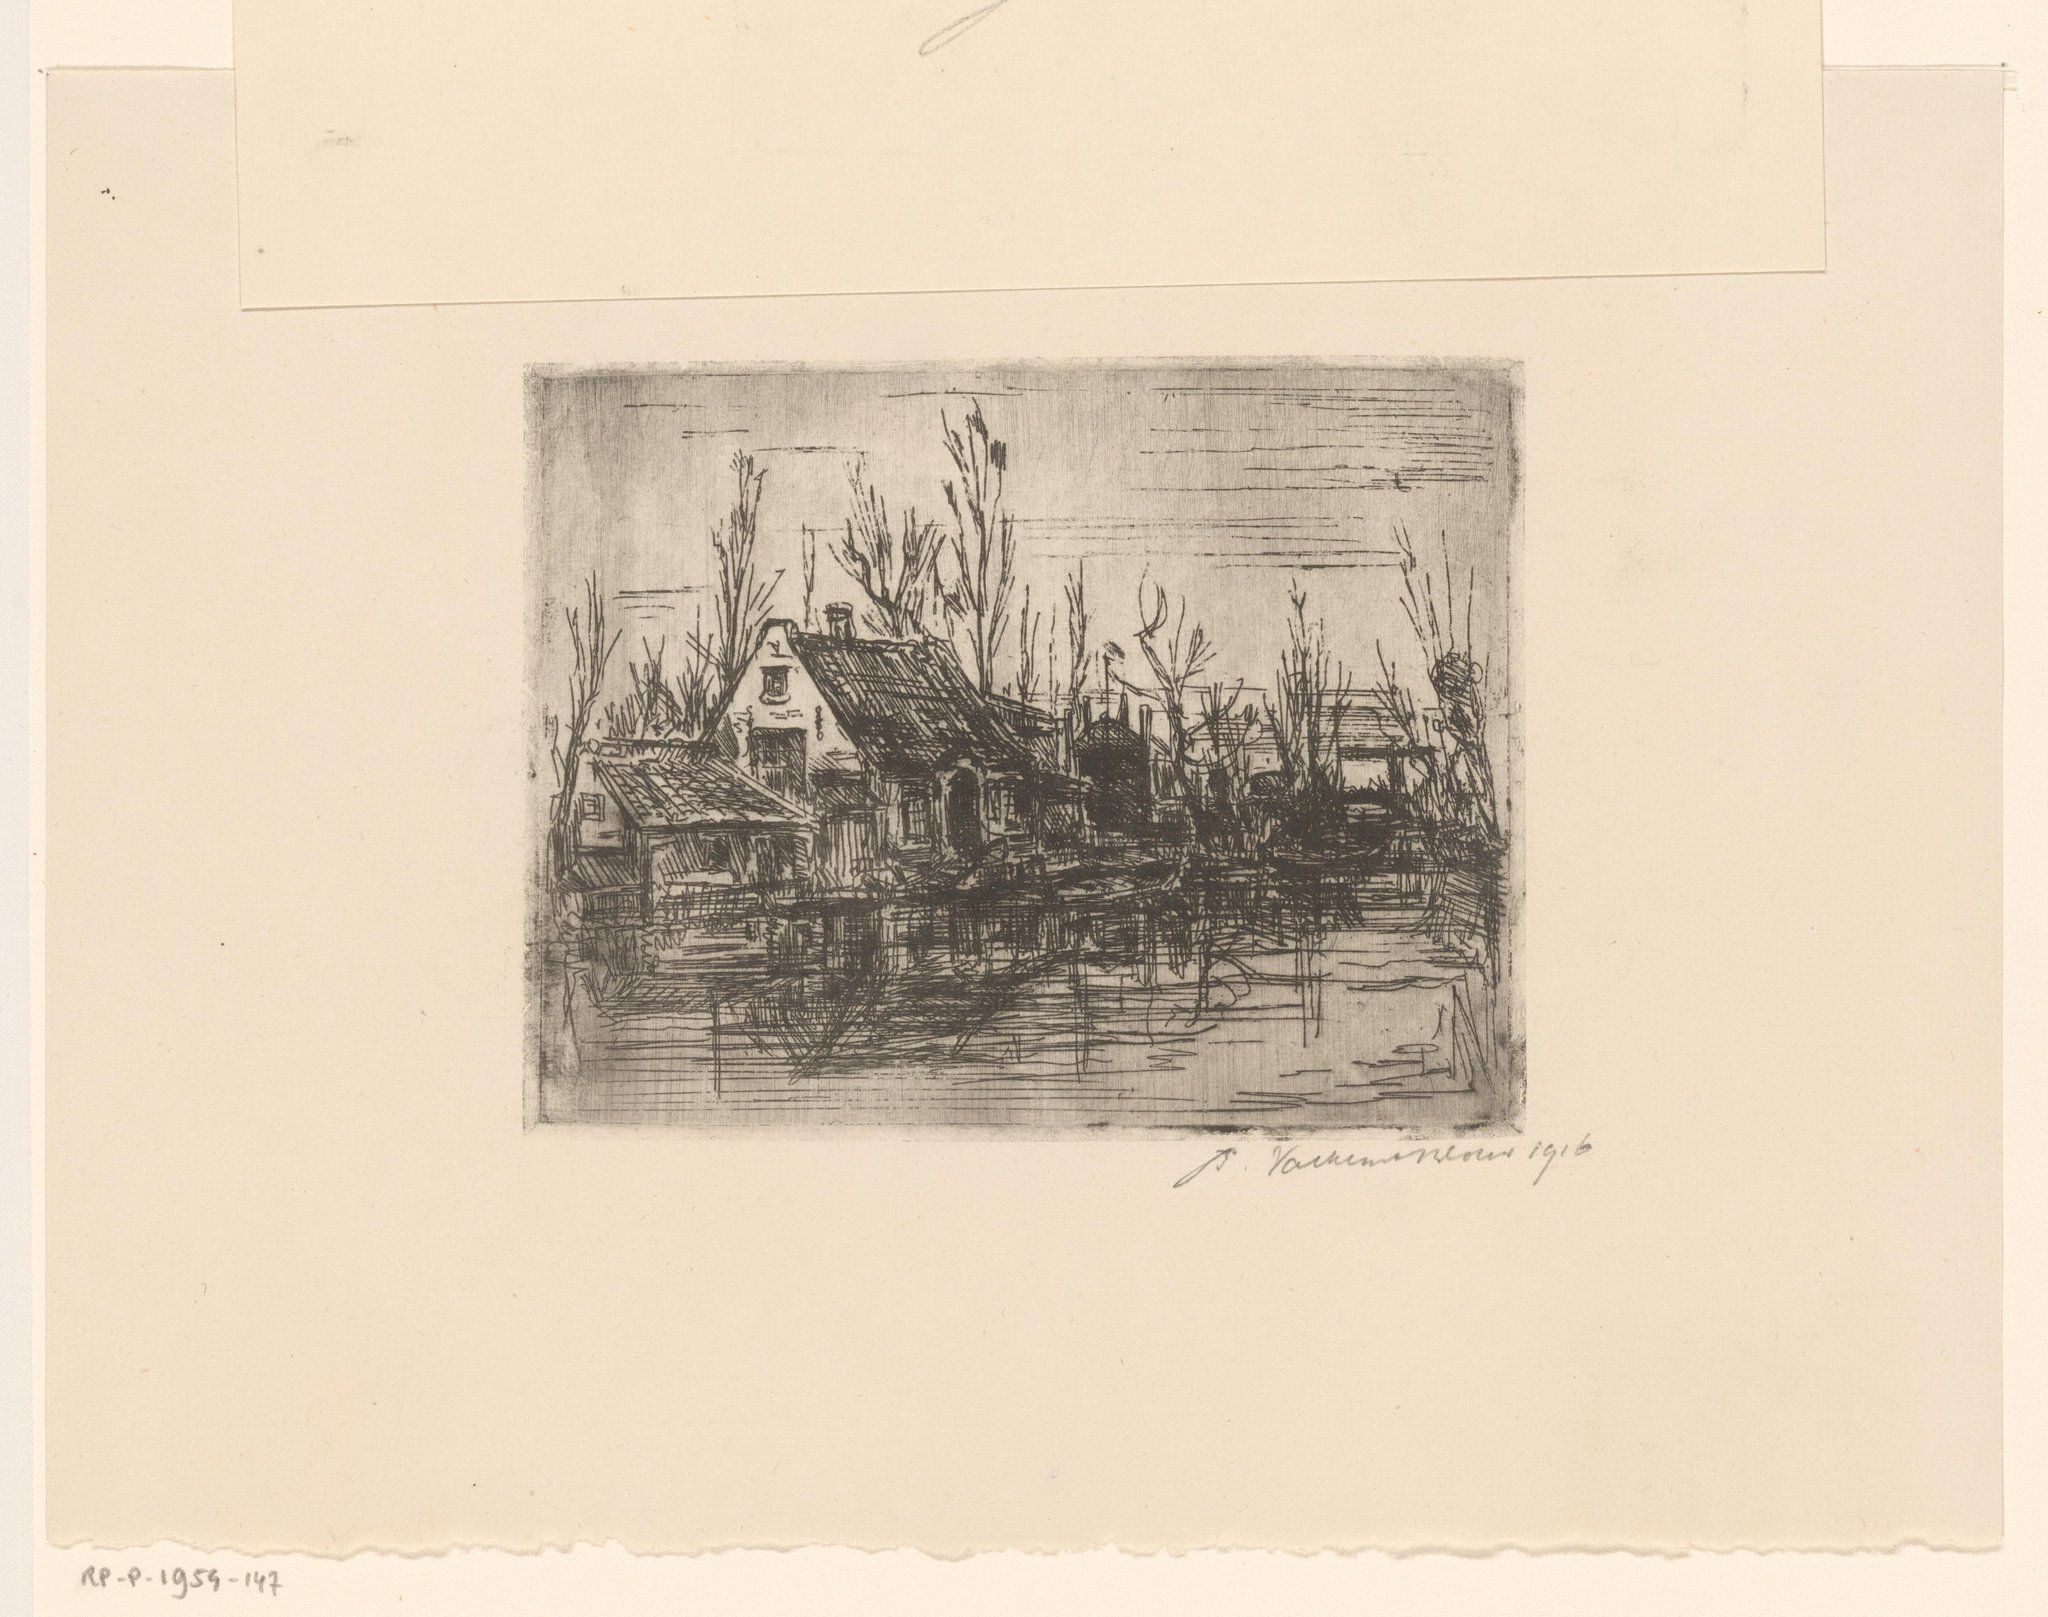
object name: print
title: Boerderij aan een plas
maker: jan paul valkema blouw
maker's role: draughtsman, print maker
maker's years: 1884-1954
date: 1916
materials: paper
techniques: etching, intaglio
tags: lake, farm or solitary house in landscape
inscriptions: collector's mark: Lugt 2760, collector's mark: Lugt 2228